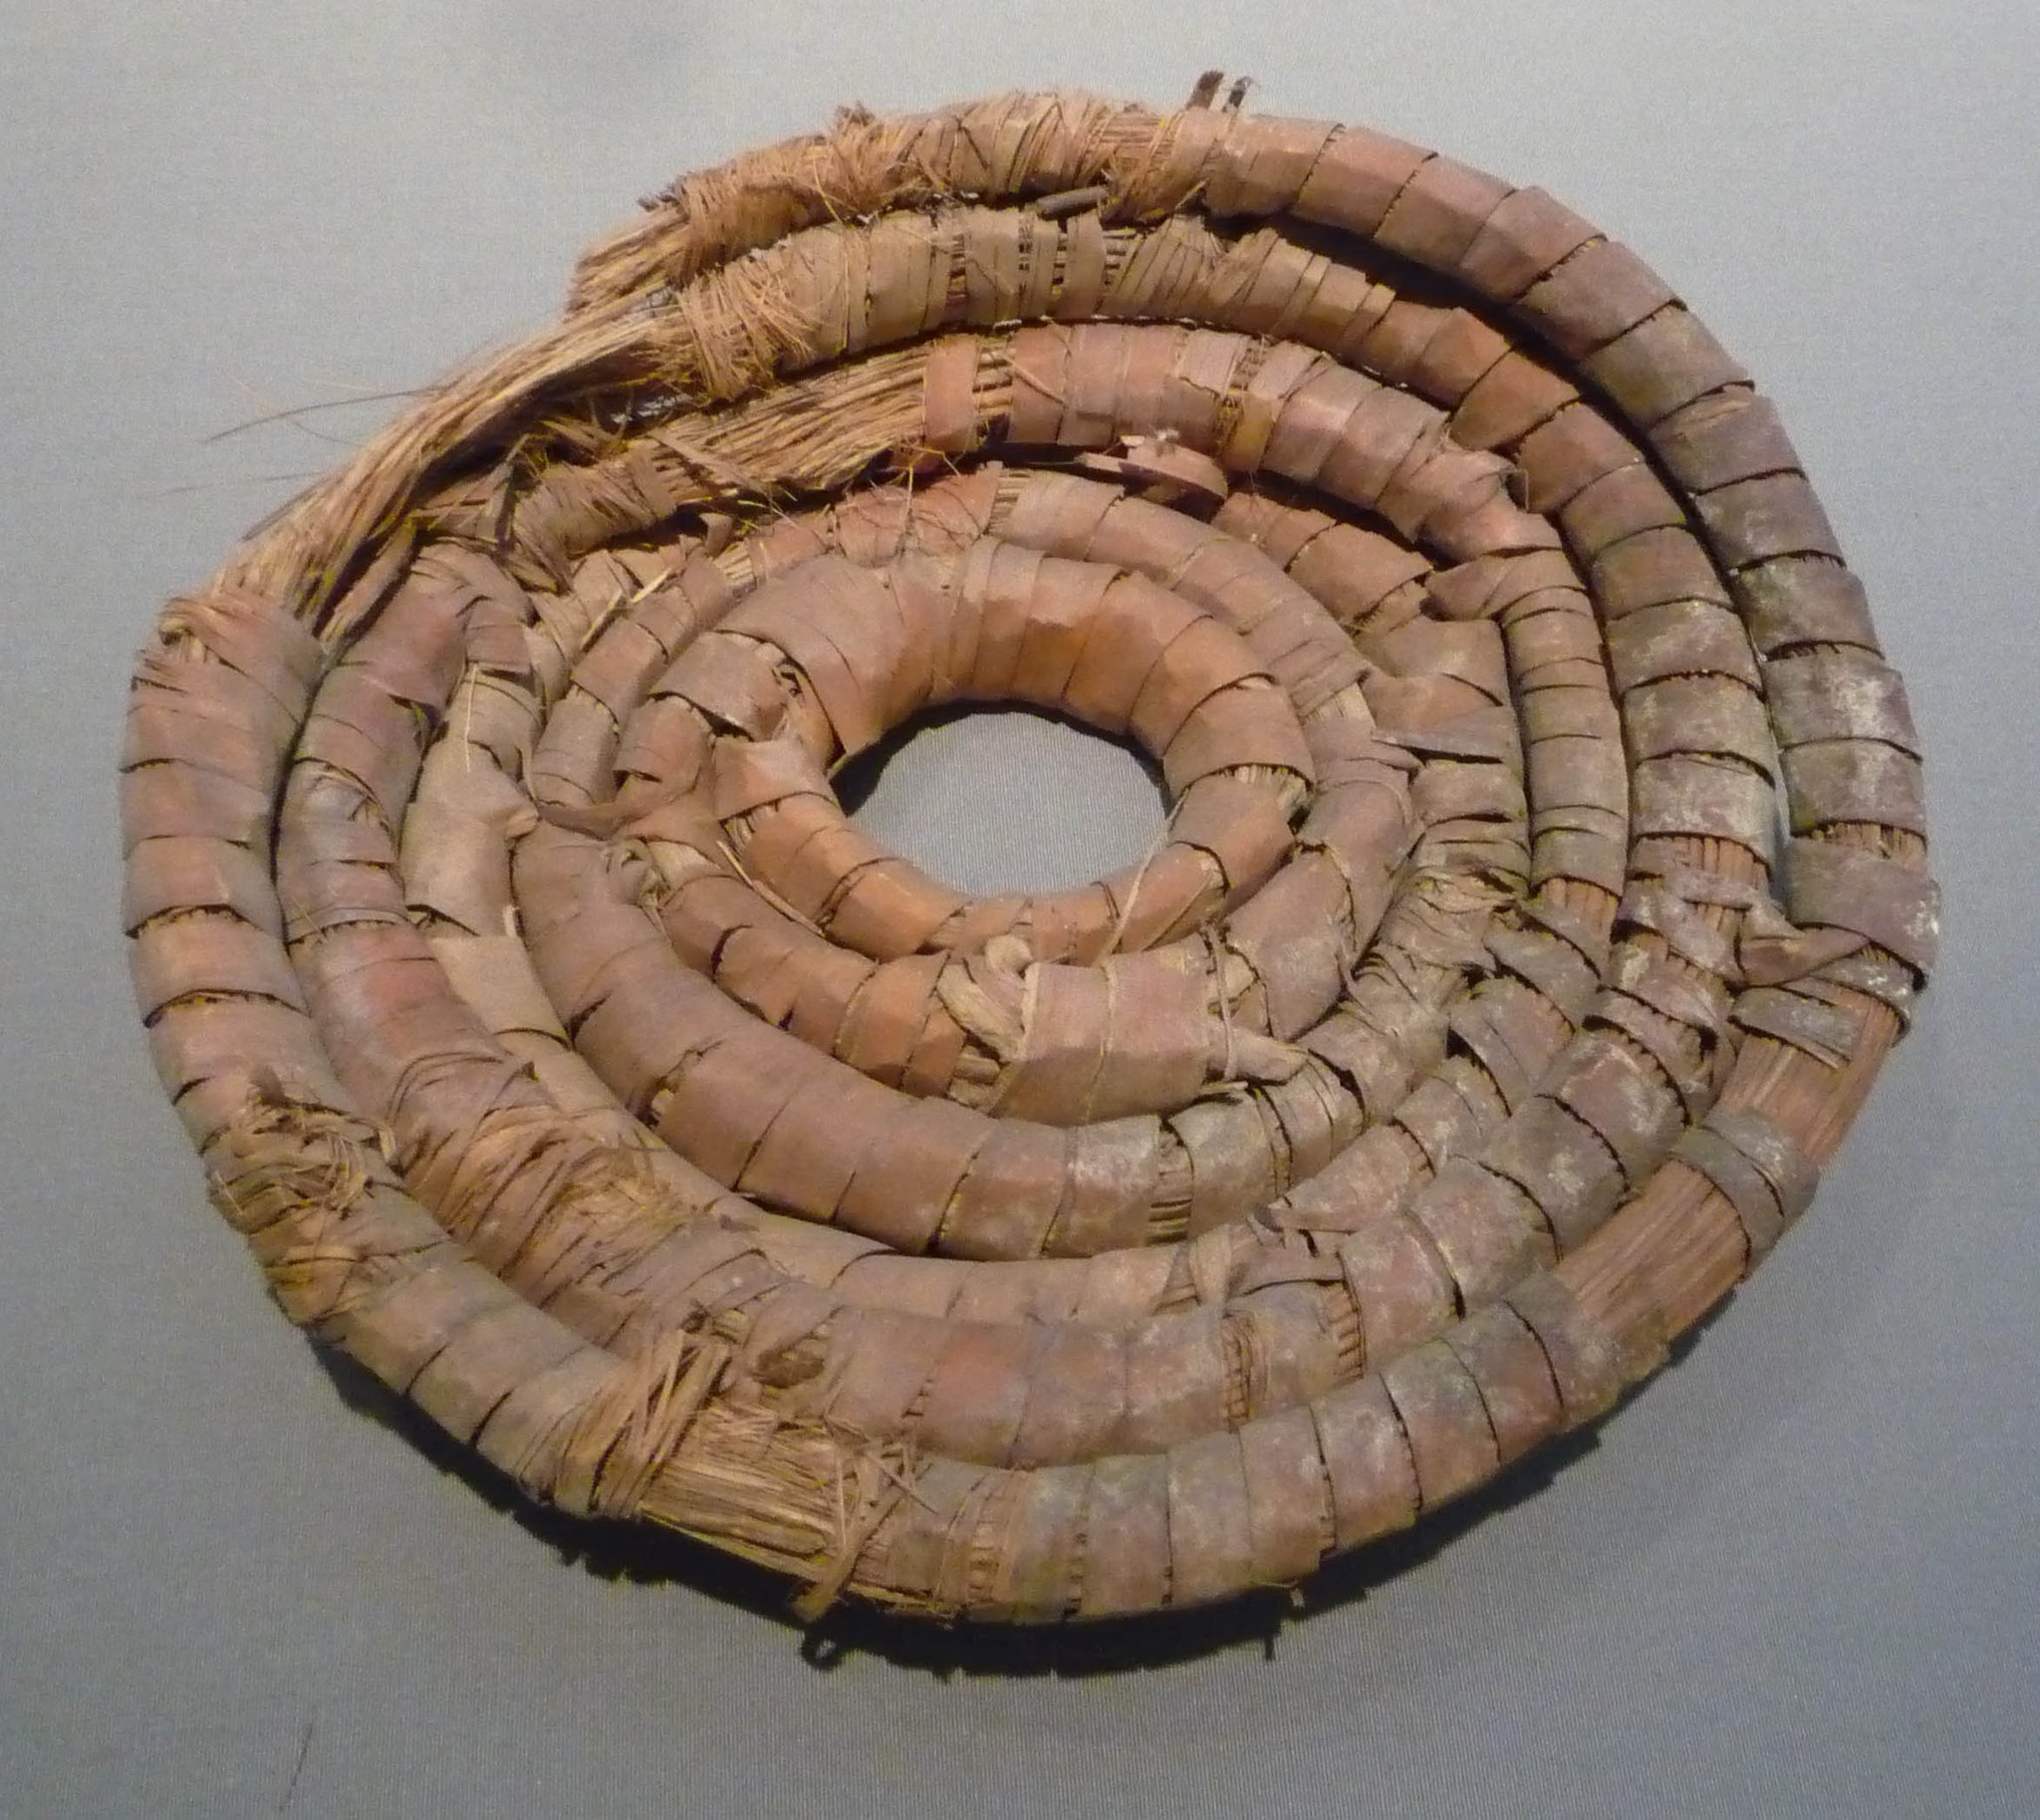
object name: mat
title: Foundation Deposit Mat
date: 1479-1458 BCE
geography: egypt